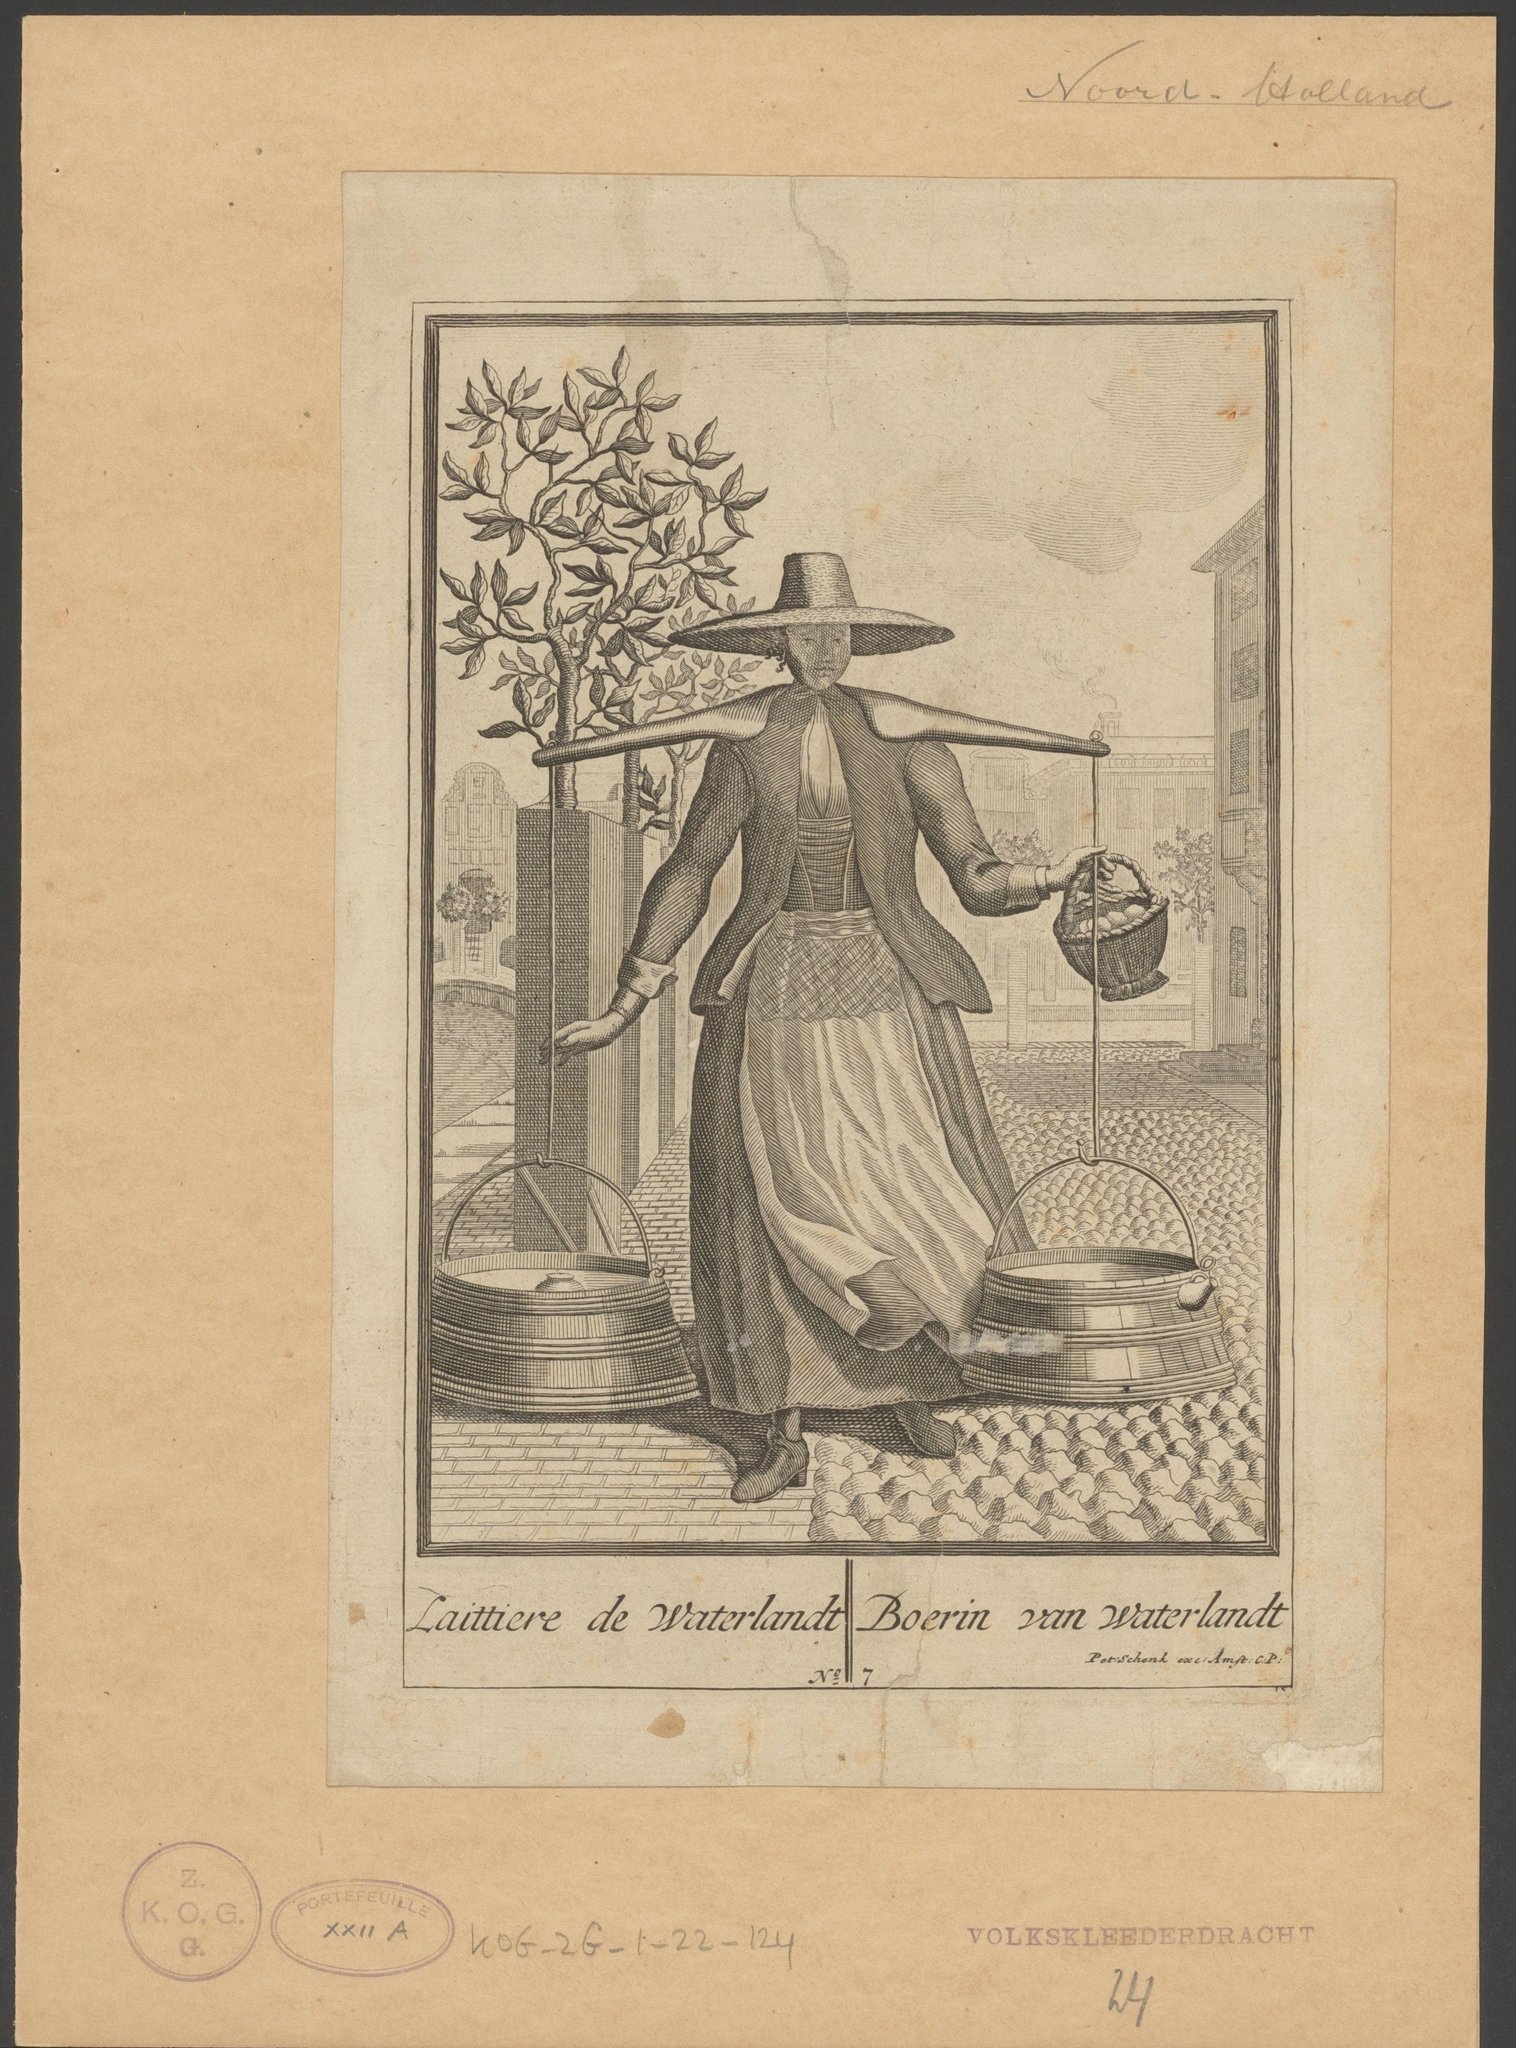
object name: print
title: Melkmeisje uit Waterland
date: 1689-1713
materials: paper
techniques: engraving, etching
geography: netherlands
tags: farmers - aa - female farmer, farmer's wife, clothes, costume (+ women's clothes), carrying something with yoke, folk costume, regional costume, milkmaid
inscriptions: collector's mark: Lugt 1641, collector's mark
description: Een melkmeisje uit Waterland draagt een juk met twee emmers melk. In haar hand houdt zij een mand met eieren. Genummerd onderaan: No. 7. Prent uit een serie prenten naar Pieter van den Berge met dorpelingen die klederdrachten dragen. Onderwerpsrubrieken binnen de Atlas Zeden en Gewoonten: De Kleeding, Volkskleederdracht, Noord-Holland.